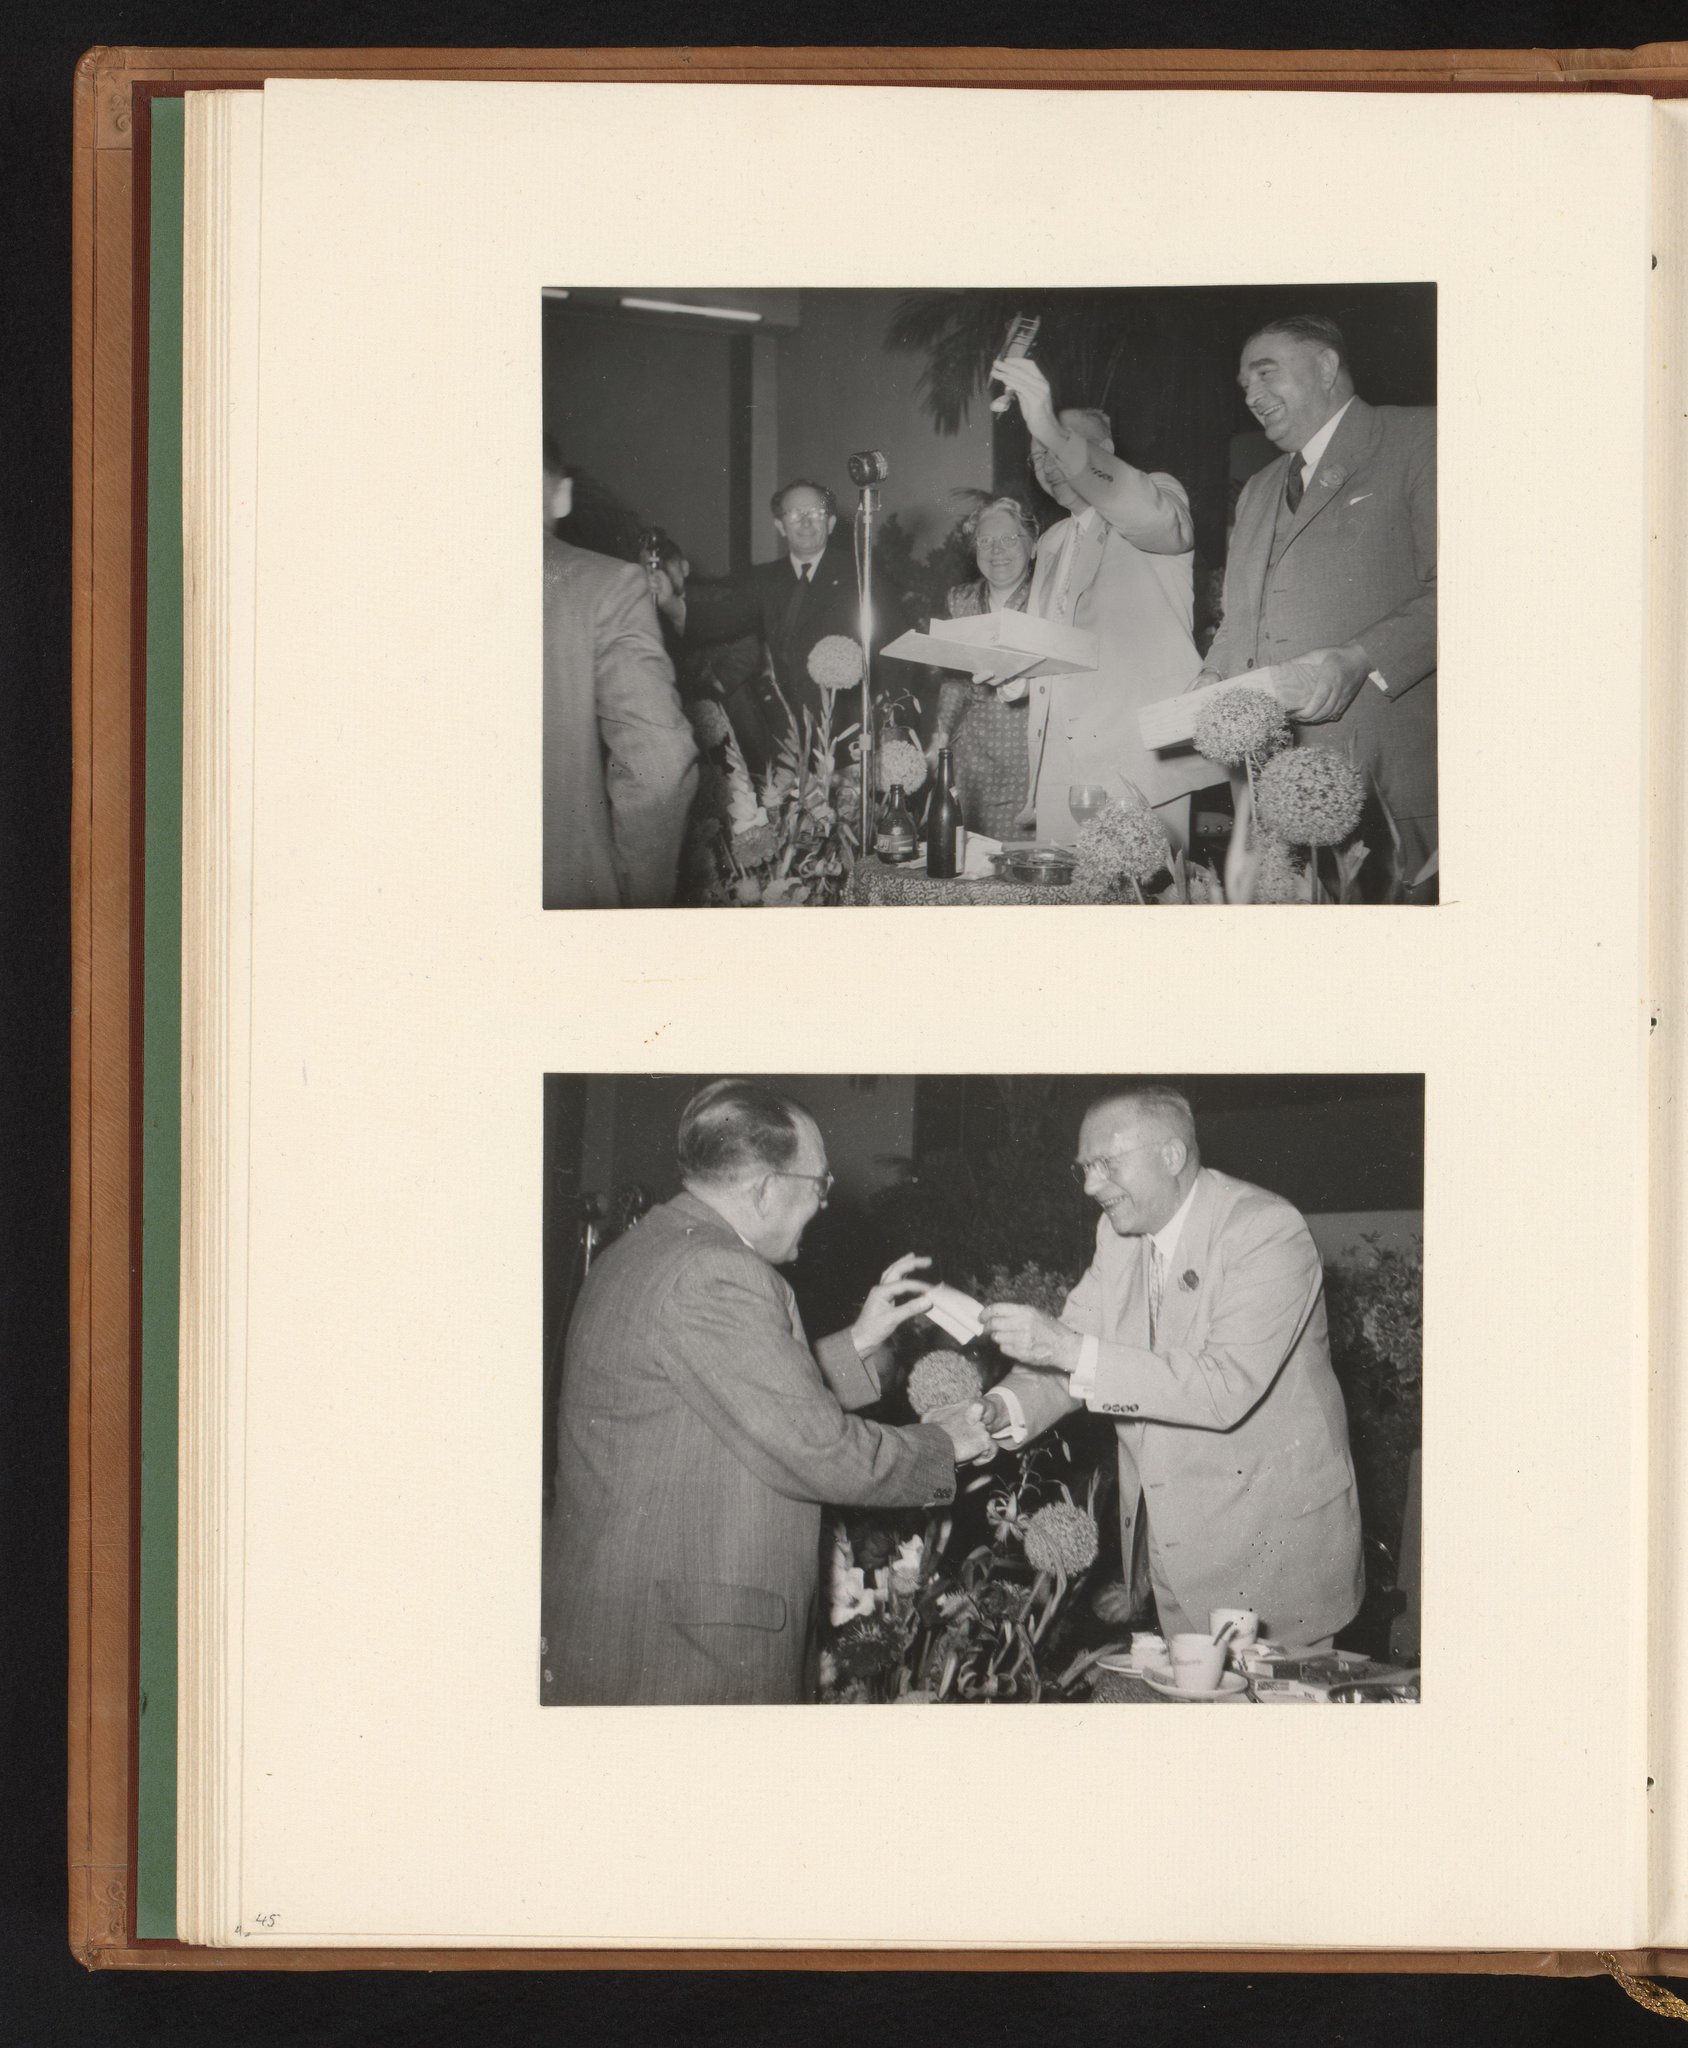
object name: photograph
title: Afscheid van Kupers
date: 1949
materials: paper, photographic support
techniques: gelatin silver print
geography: amsterdam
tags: gifts being accepted, modern professional organization, trade union, reception, cocktail party, amsterdam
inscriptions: company name: ‘Fotodienst Het Vrije Volk / Hekelveld 15, Amsterdam’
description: Blad met twee foto's waarin Kupers cadeaus in ontvangst neemt. Onderdeel van het fotoalbum ter gelegenheid van het afscheid van Evert Kupers als voorzitter van de NVV op 14 juli 1949 in Amsterdam.